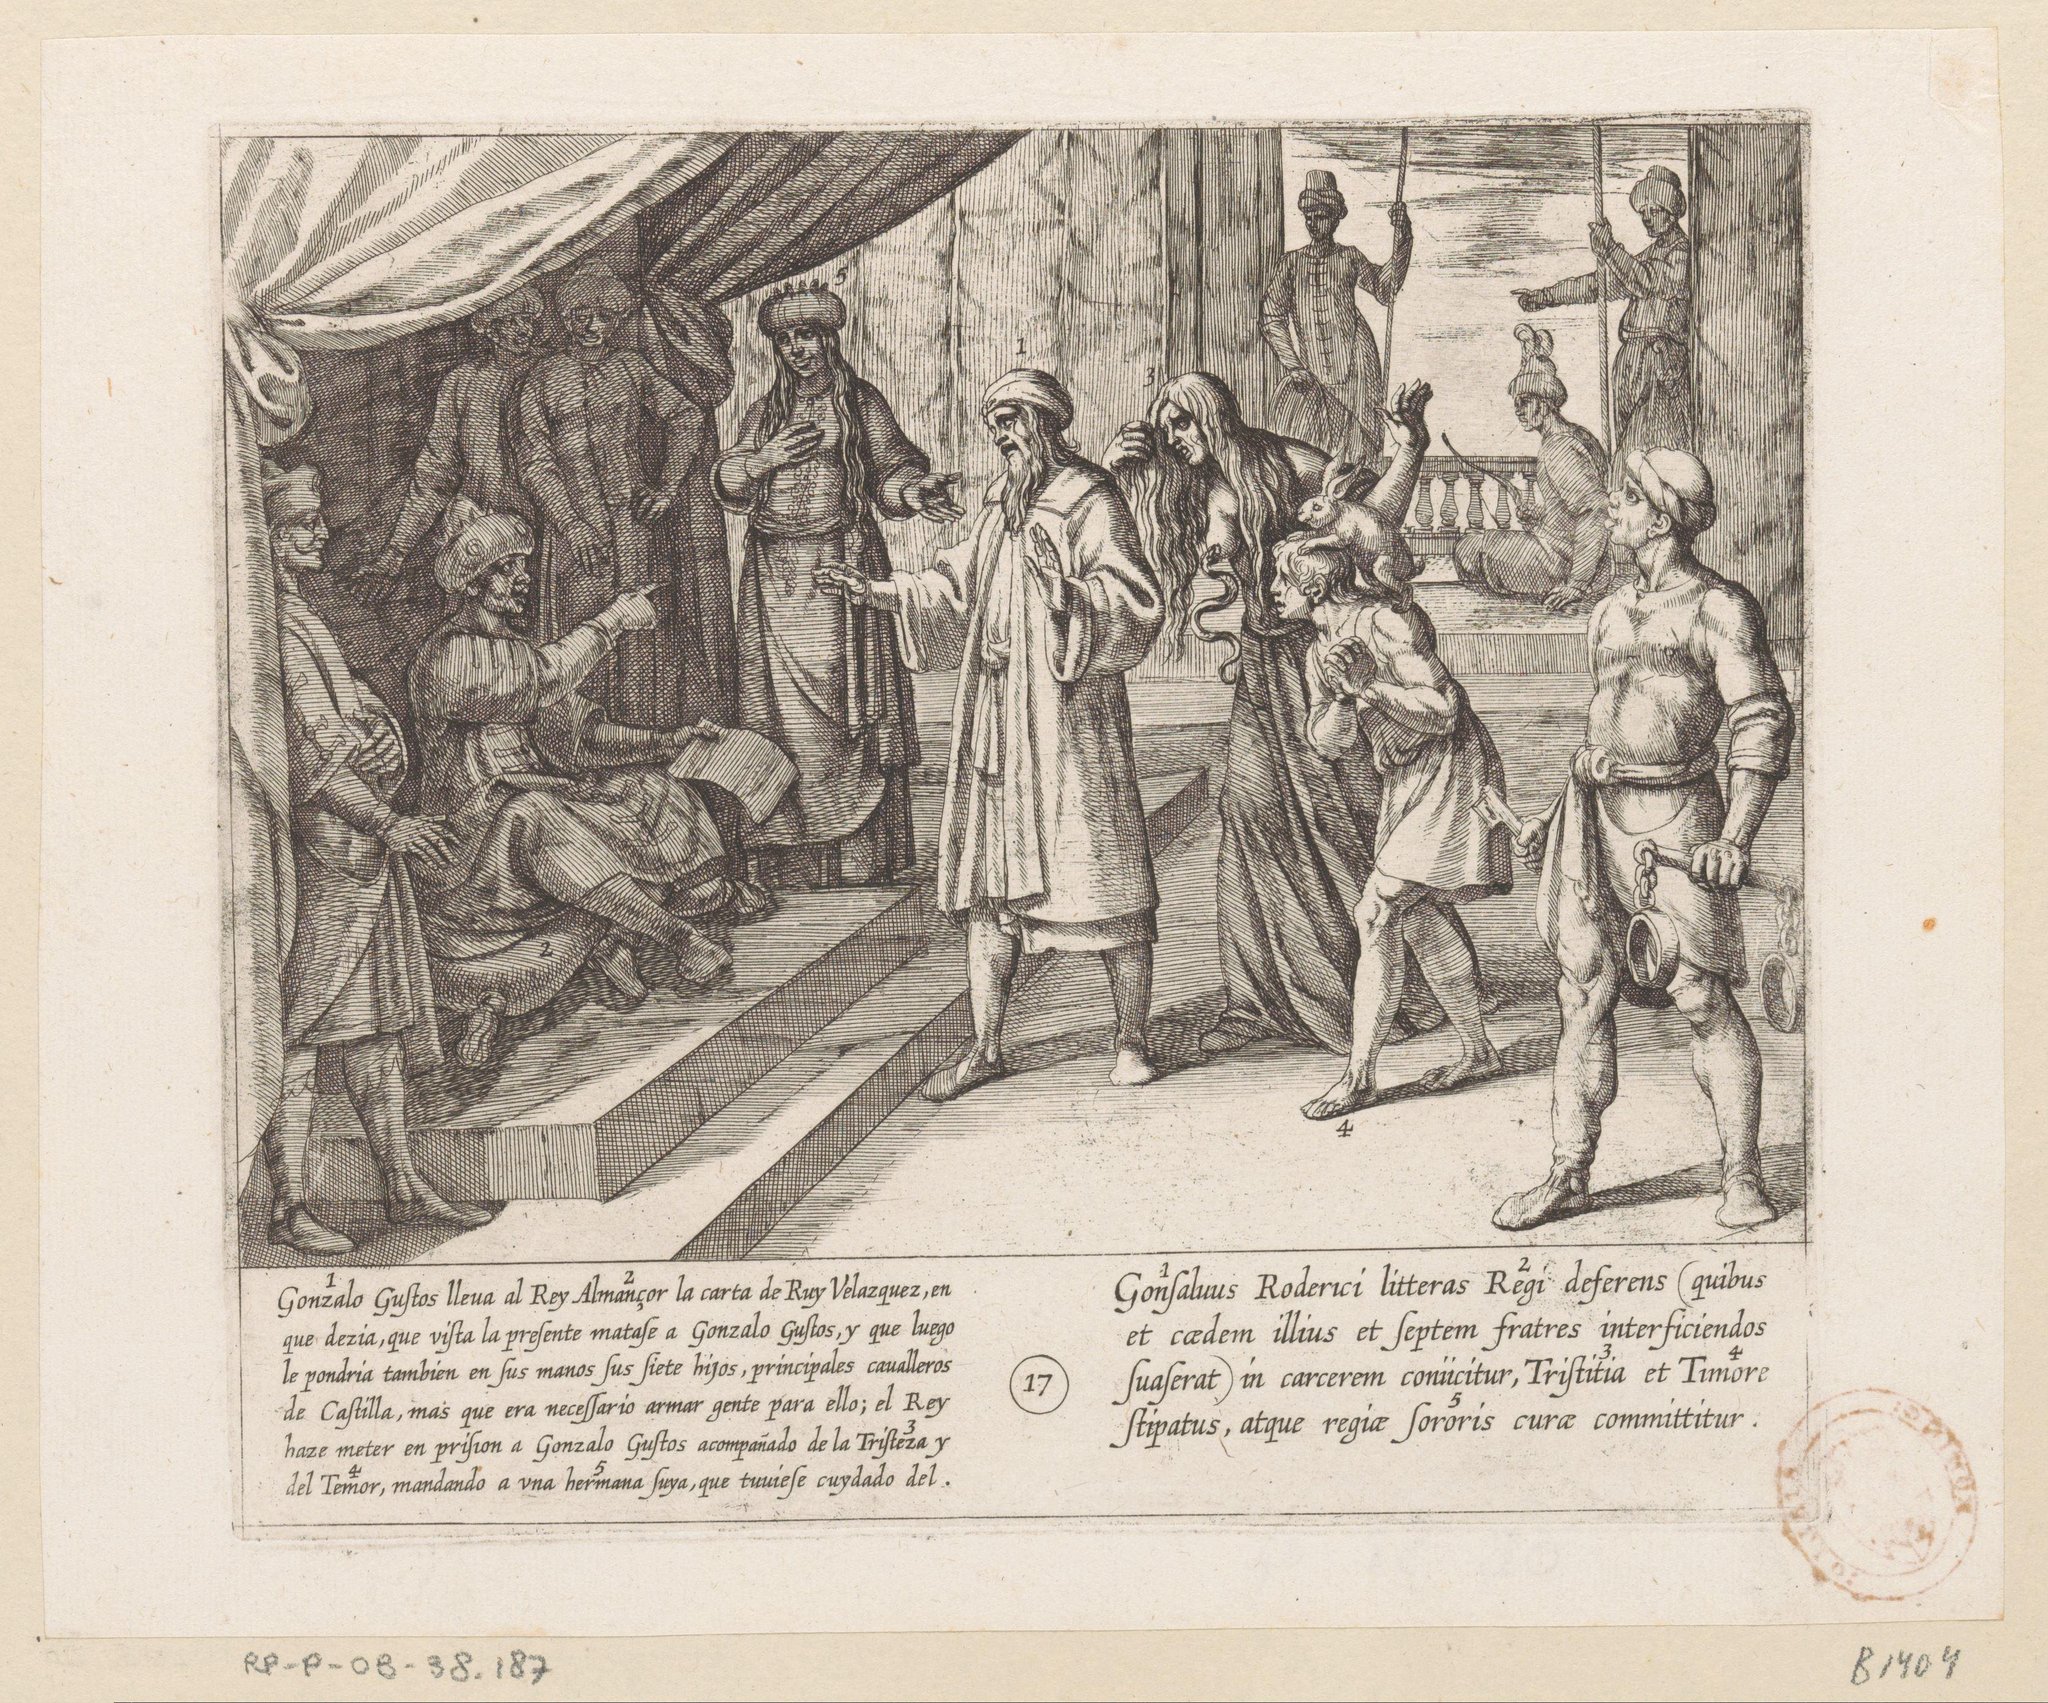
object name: print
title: De zeven infanten van Lara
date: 1612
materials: paper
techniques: etching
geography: antwerp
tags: palace, head-gear: turban, tales and fairy tales, letter, envelope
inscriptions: collector's mark: Lugt 240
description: Deze prent maakt deel uit van een reeks van 40 prenten (+ titelprent) met voorstellingen uit het volksverhaal over de zeven infanten van Lara.